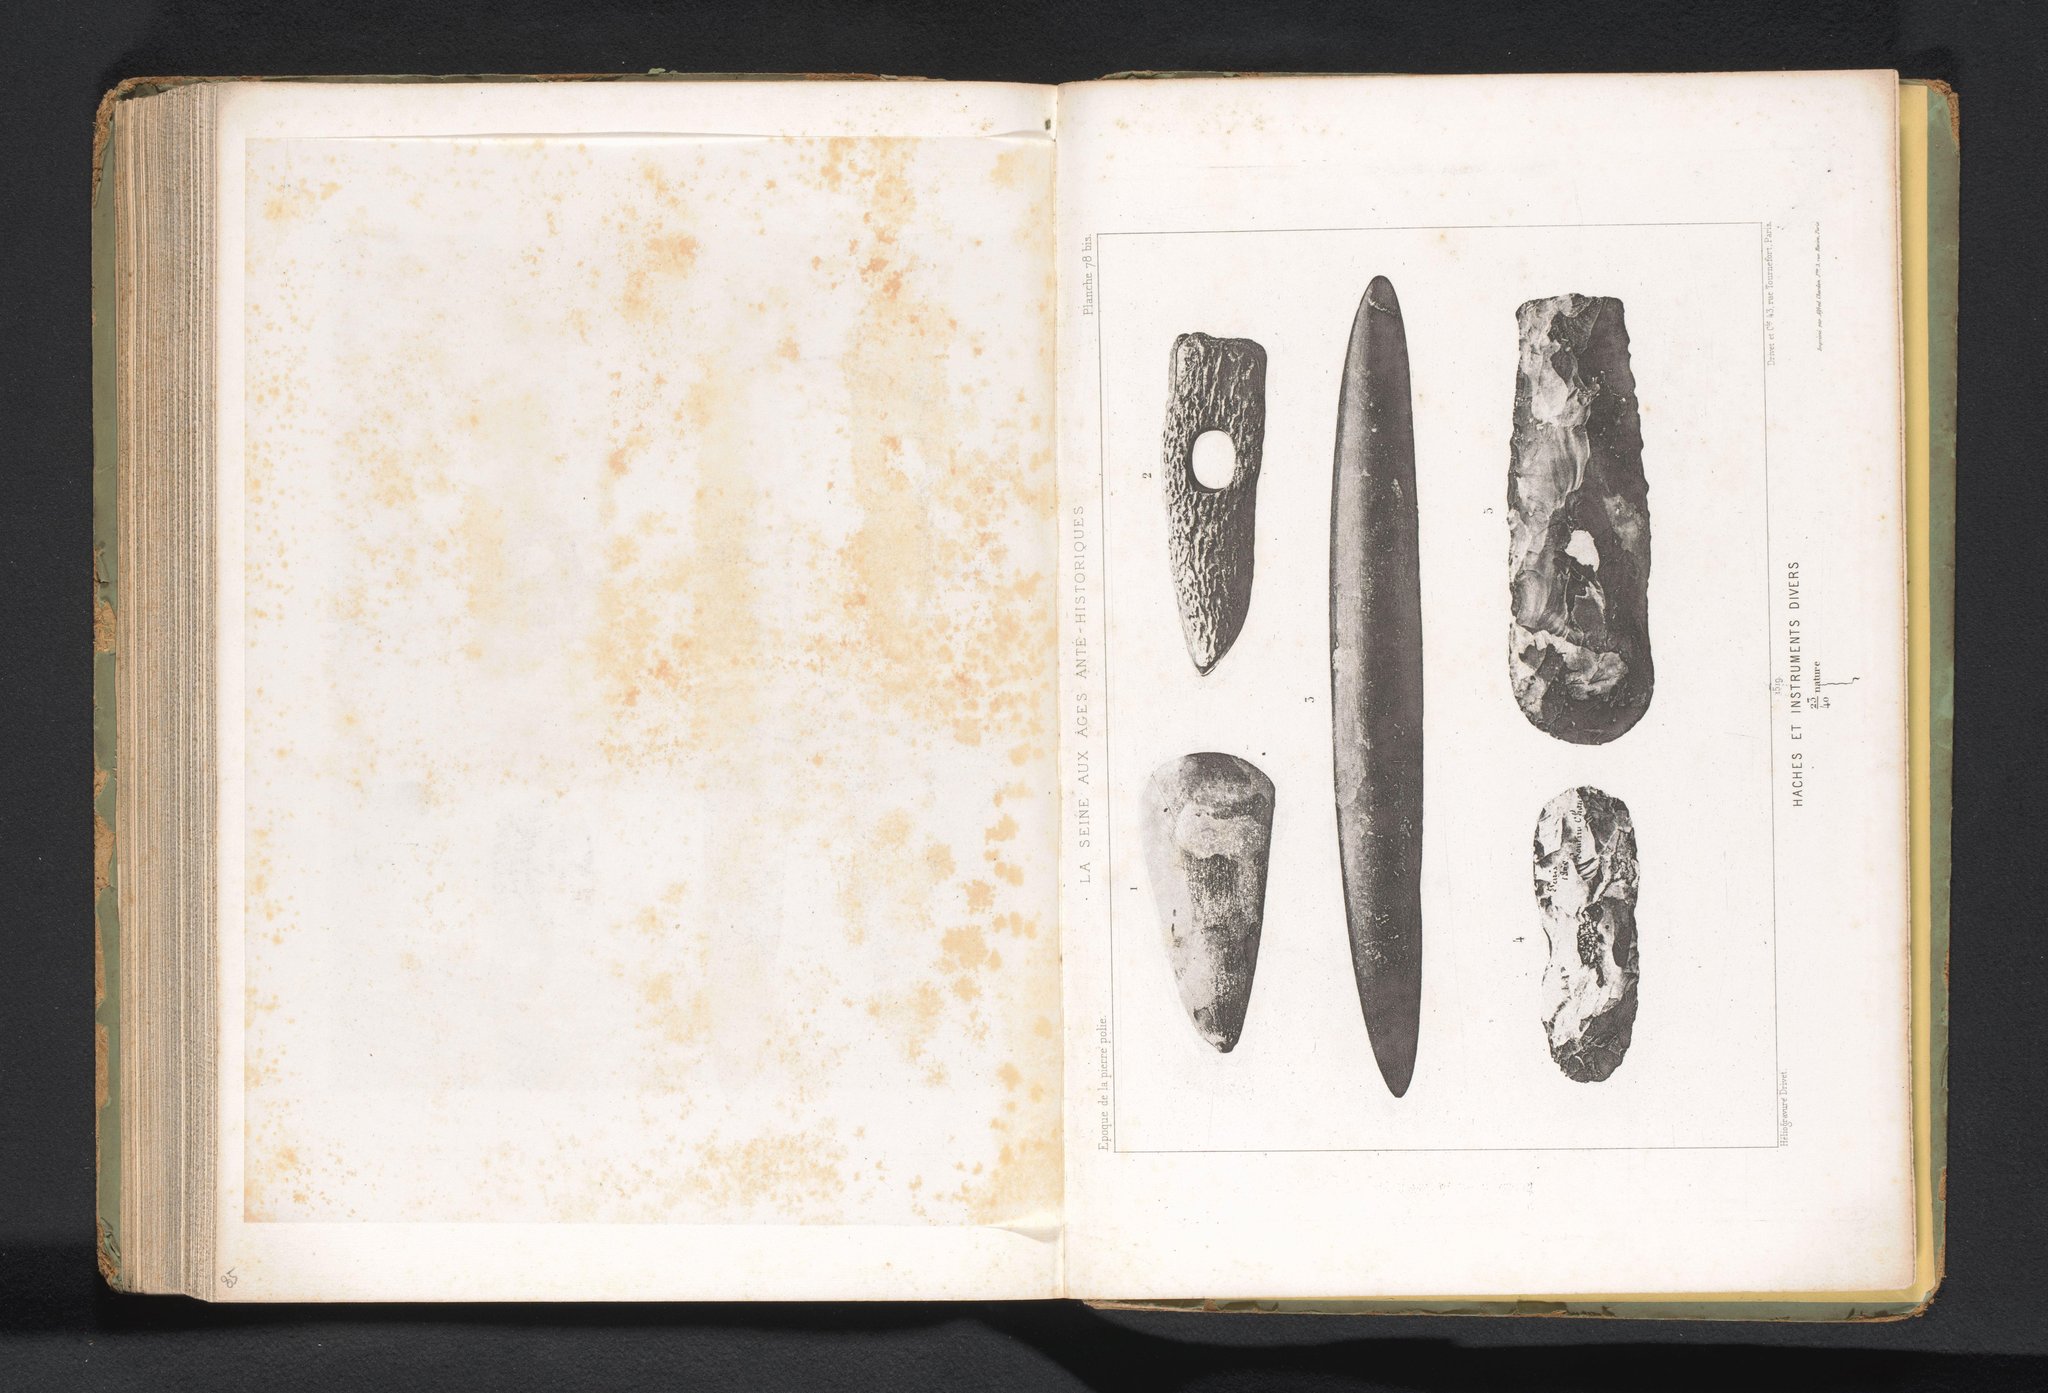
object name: page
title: Diverse bijlen en gereedschappen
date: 1864-1869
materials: paper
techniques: photoaquatint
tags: tools, aids, implements ~ crafts and industries: axe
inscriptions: inscription: ‘23/40 nature’, inscription: ‘1519’